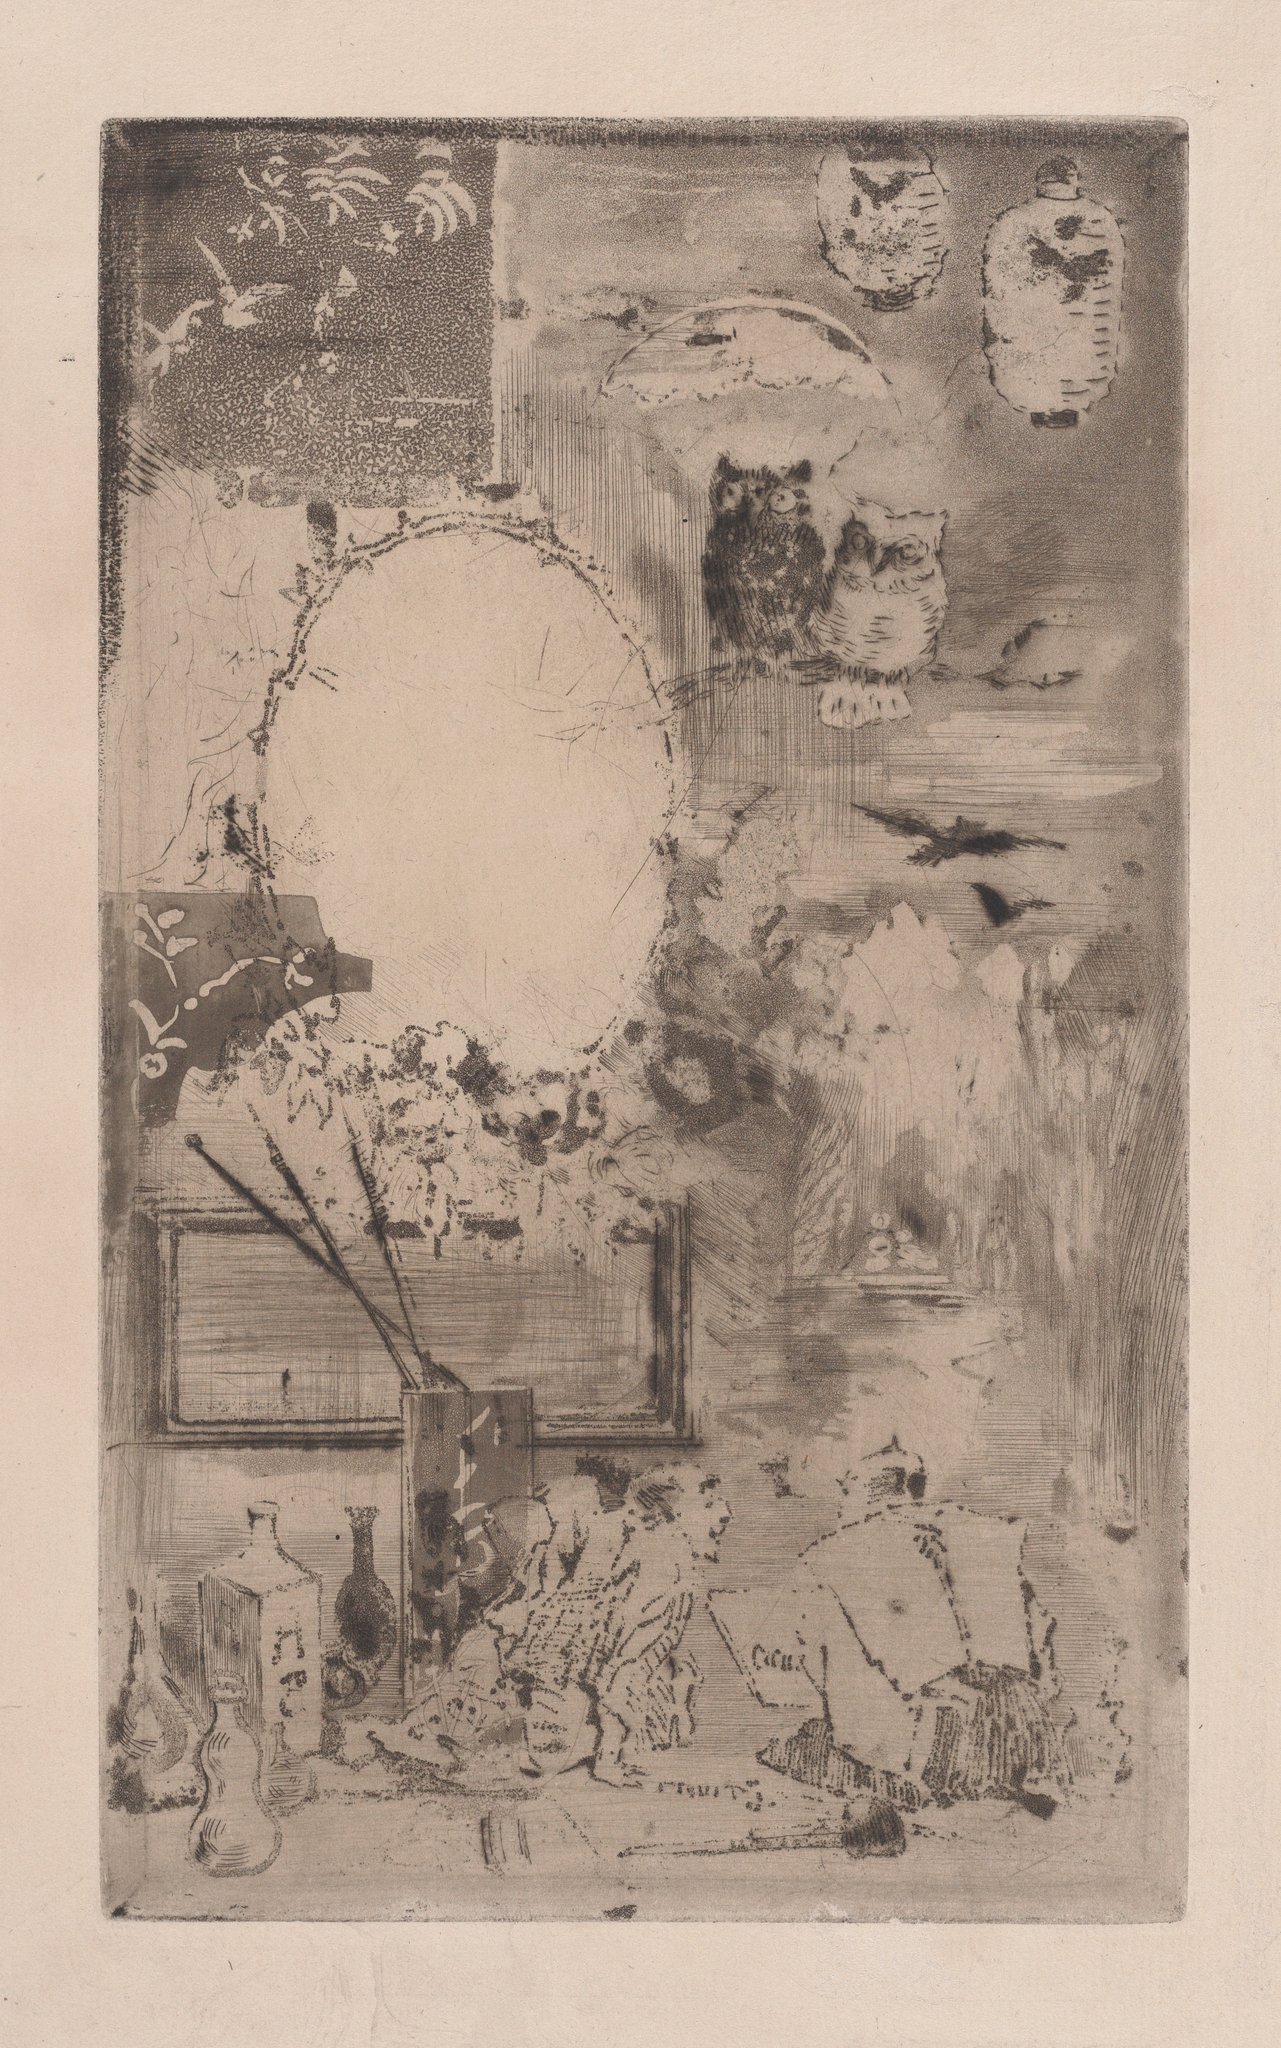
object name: print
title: Japanese Baptism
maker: félix-hilaire buhot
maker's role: artist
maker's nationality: french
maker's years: 1847-1898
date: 1860-1898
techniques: aquatint, etching